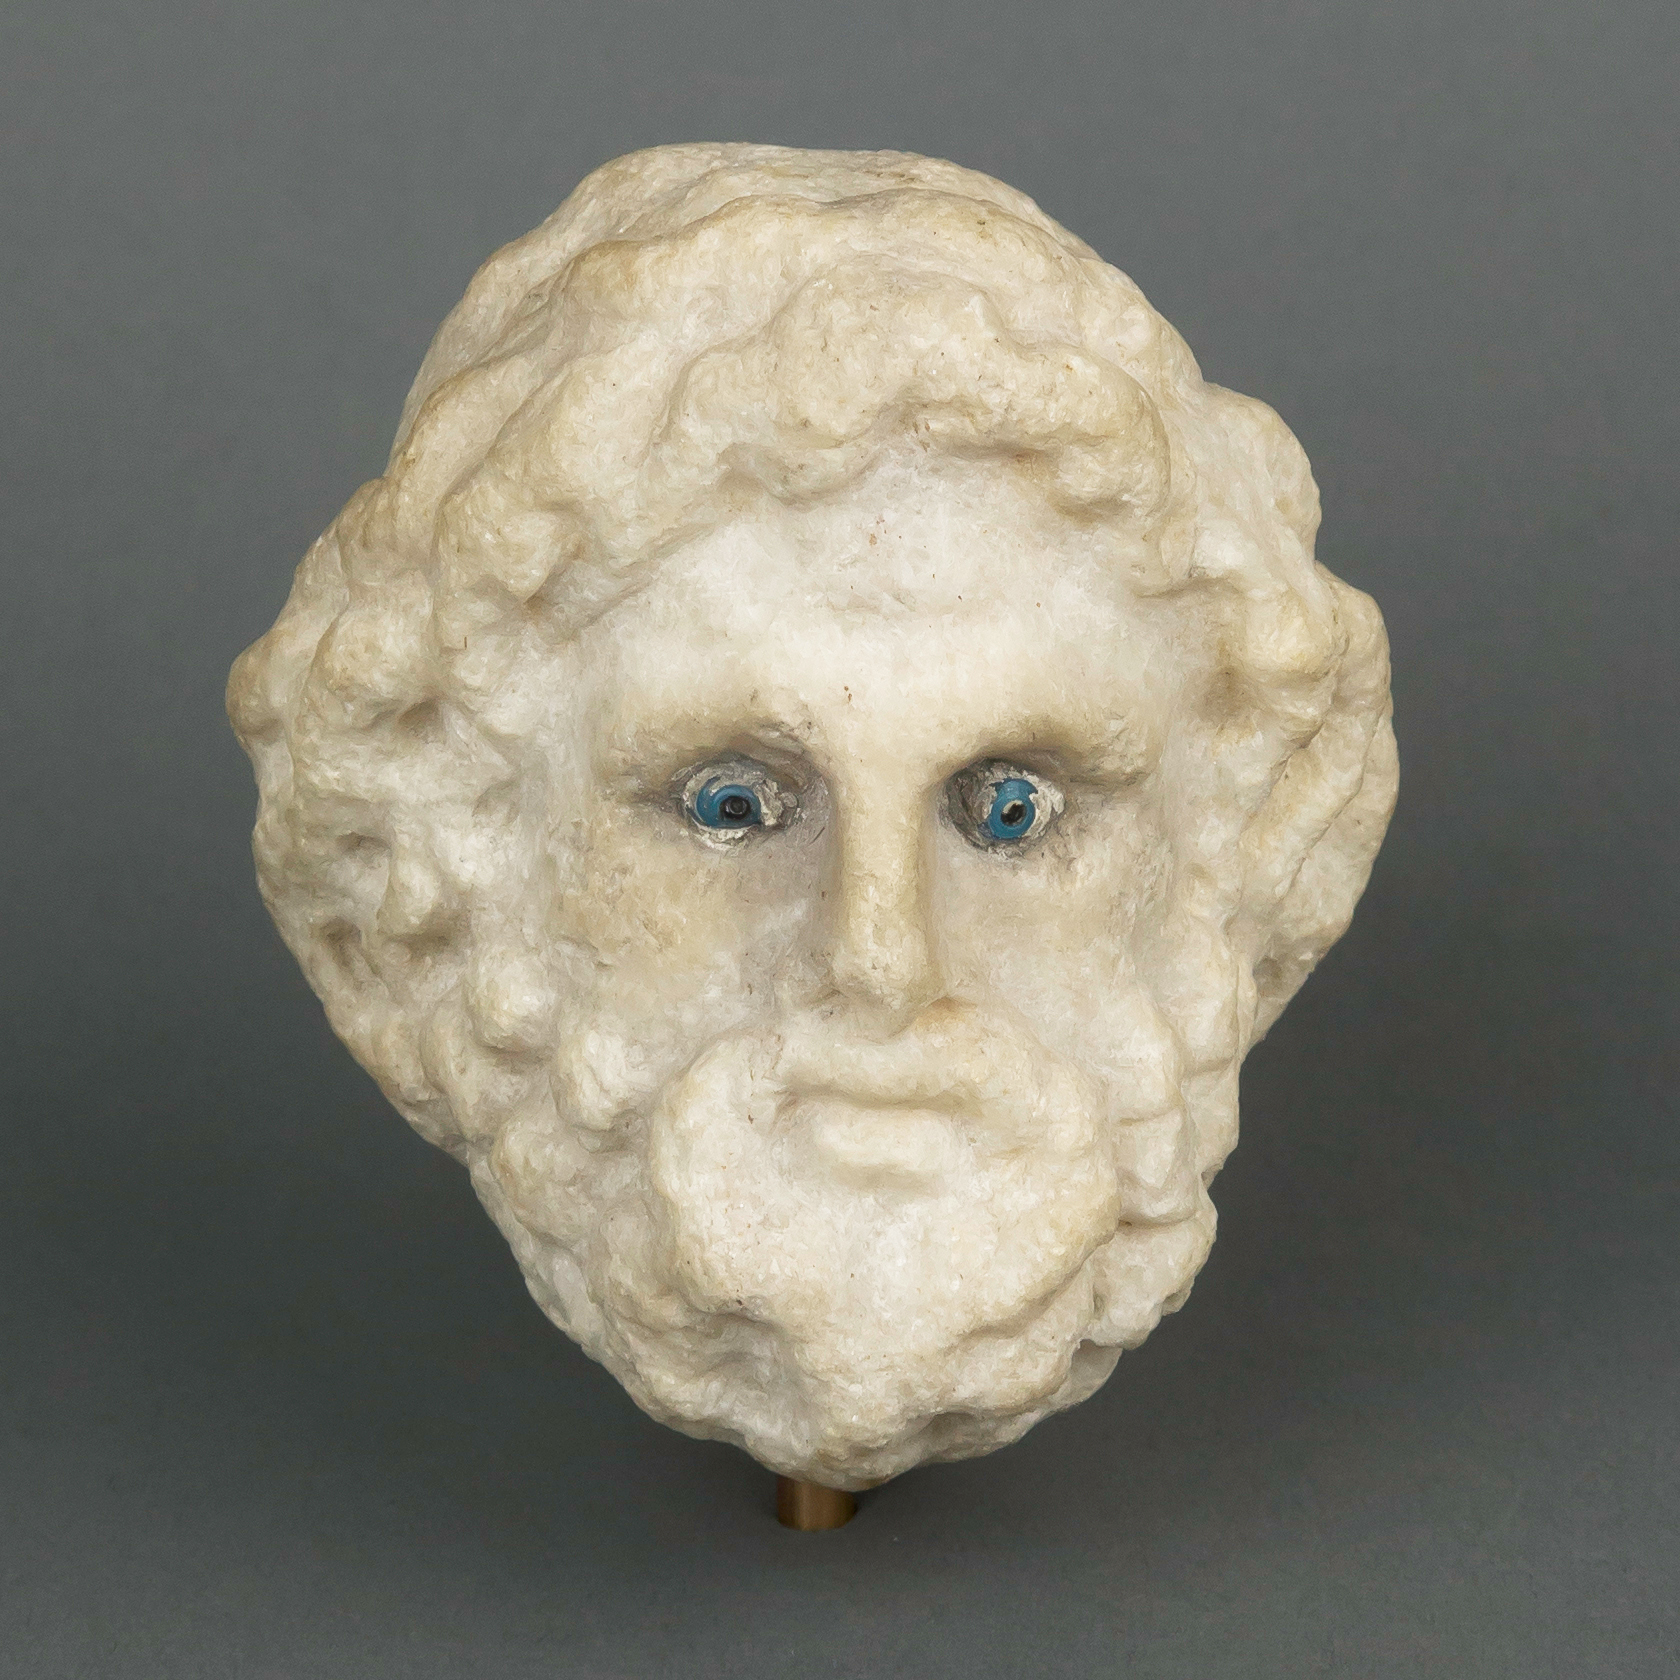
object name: head of asklepios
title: Head of a marble statuette of Asklepios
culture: roman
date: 300-101 BCE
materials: marble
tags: heads